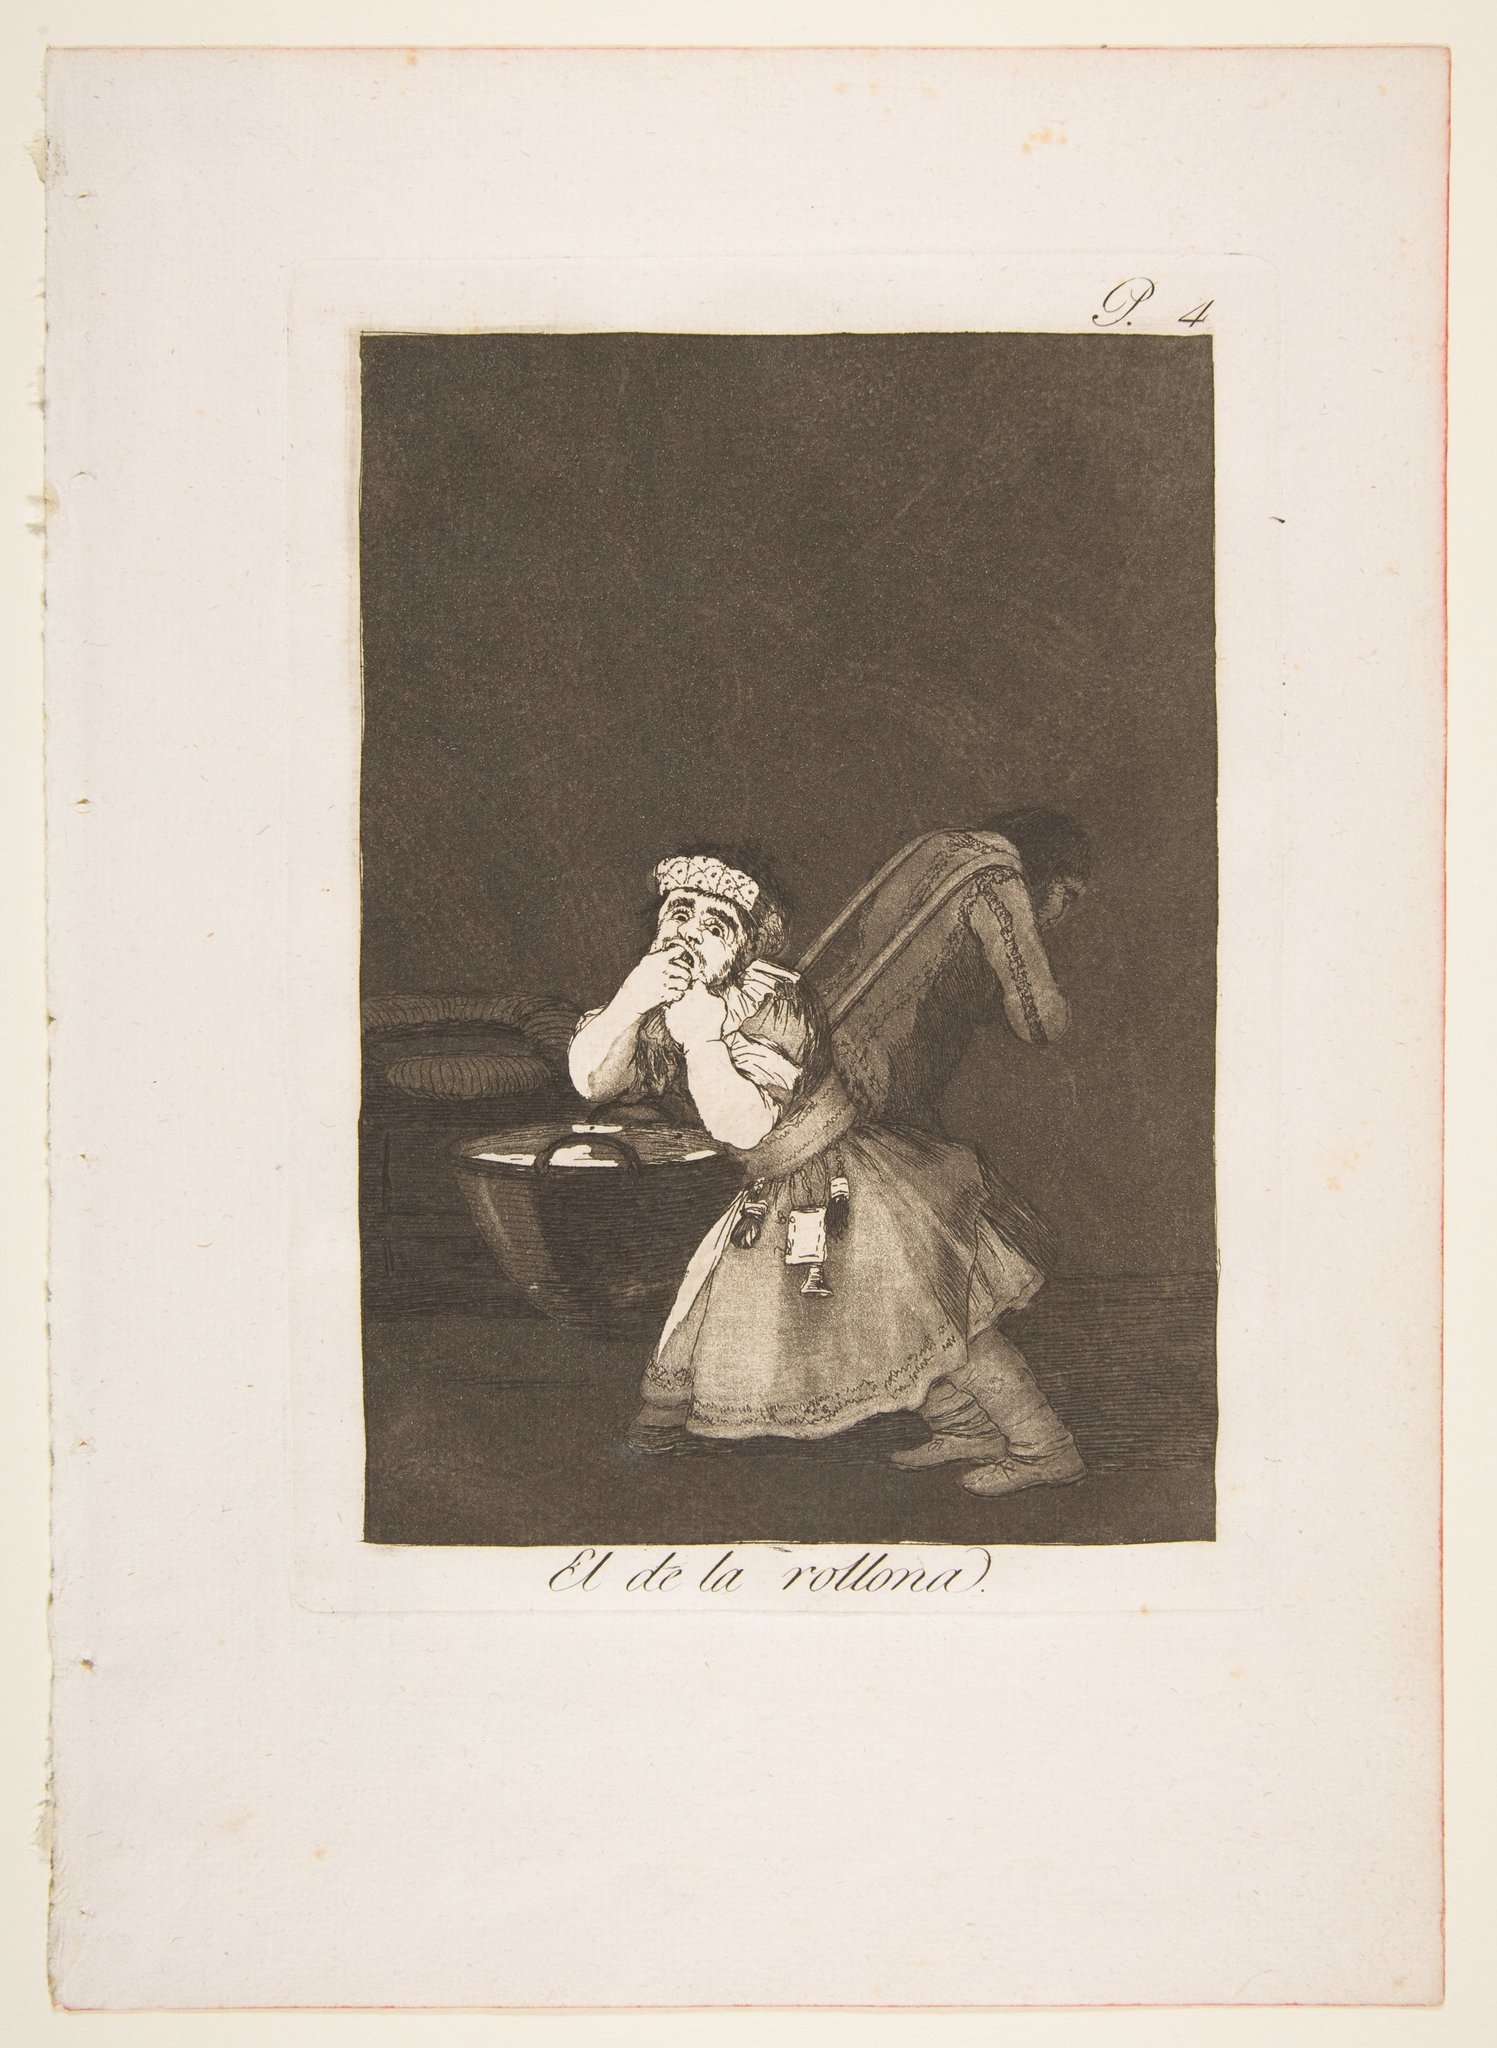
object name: print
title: Plate 4 from "Los Caprichos": Nanny's boy (El de la rollona)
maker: goya (francisco de goya y lucientes)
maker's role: artist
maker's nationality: spanish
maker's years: 1746-1828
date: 1799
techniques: aquatint, burnishing, etching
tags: boys